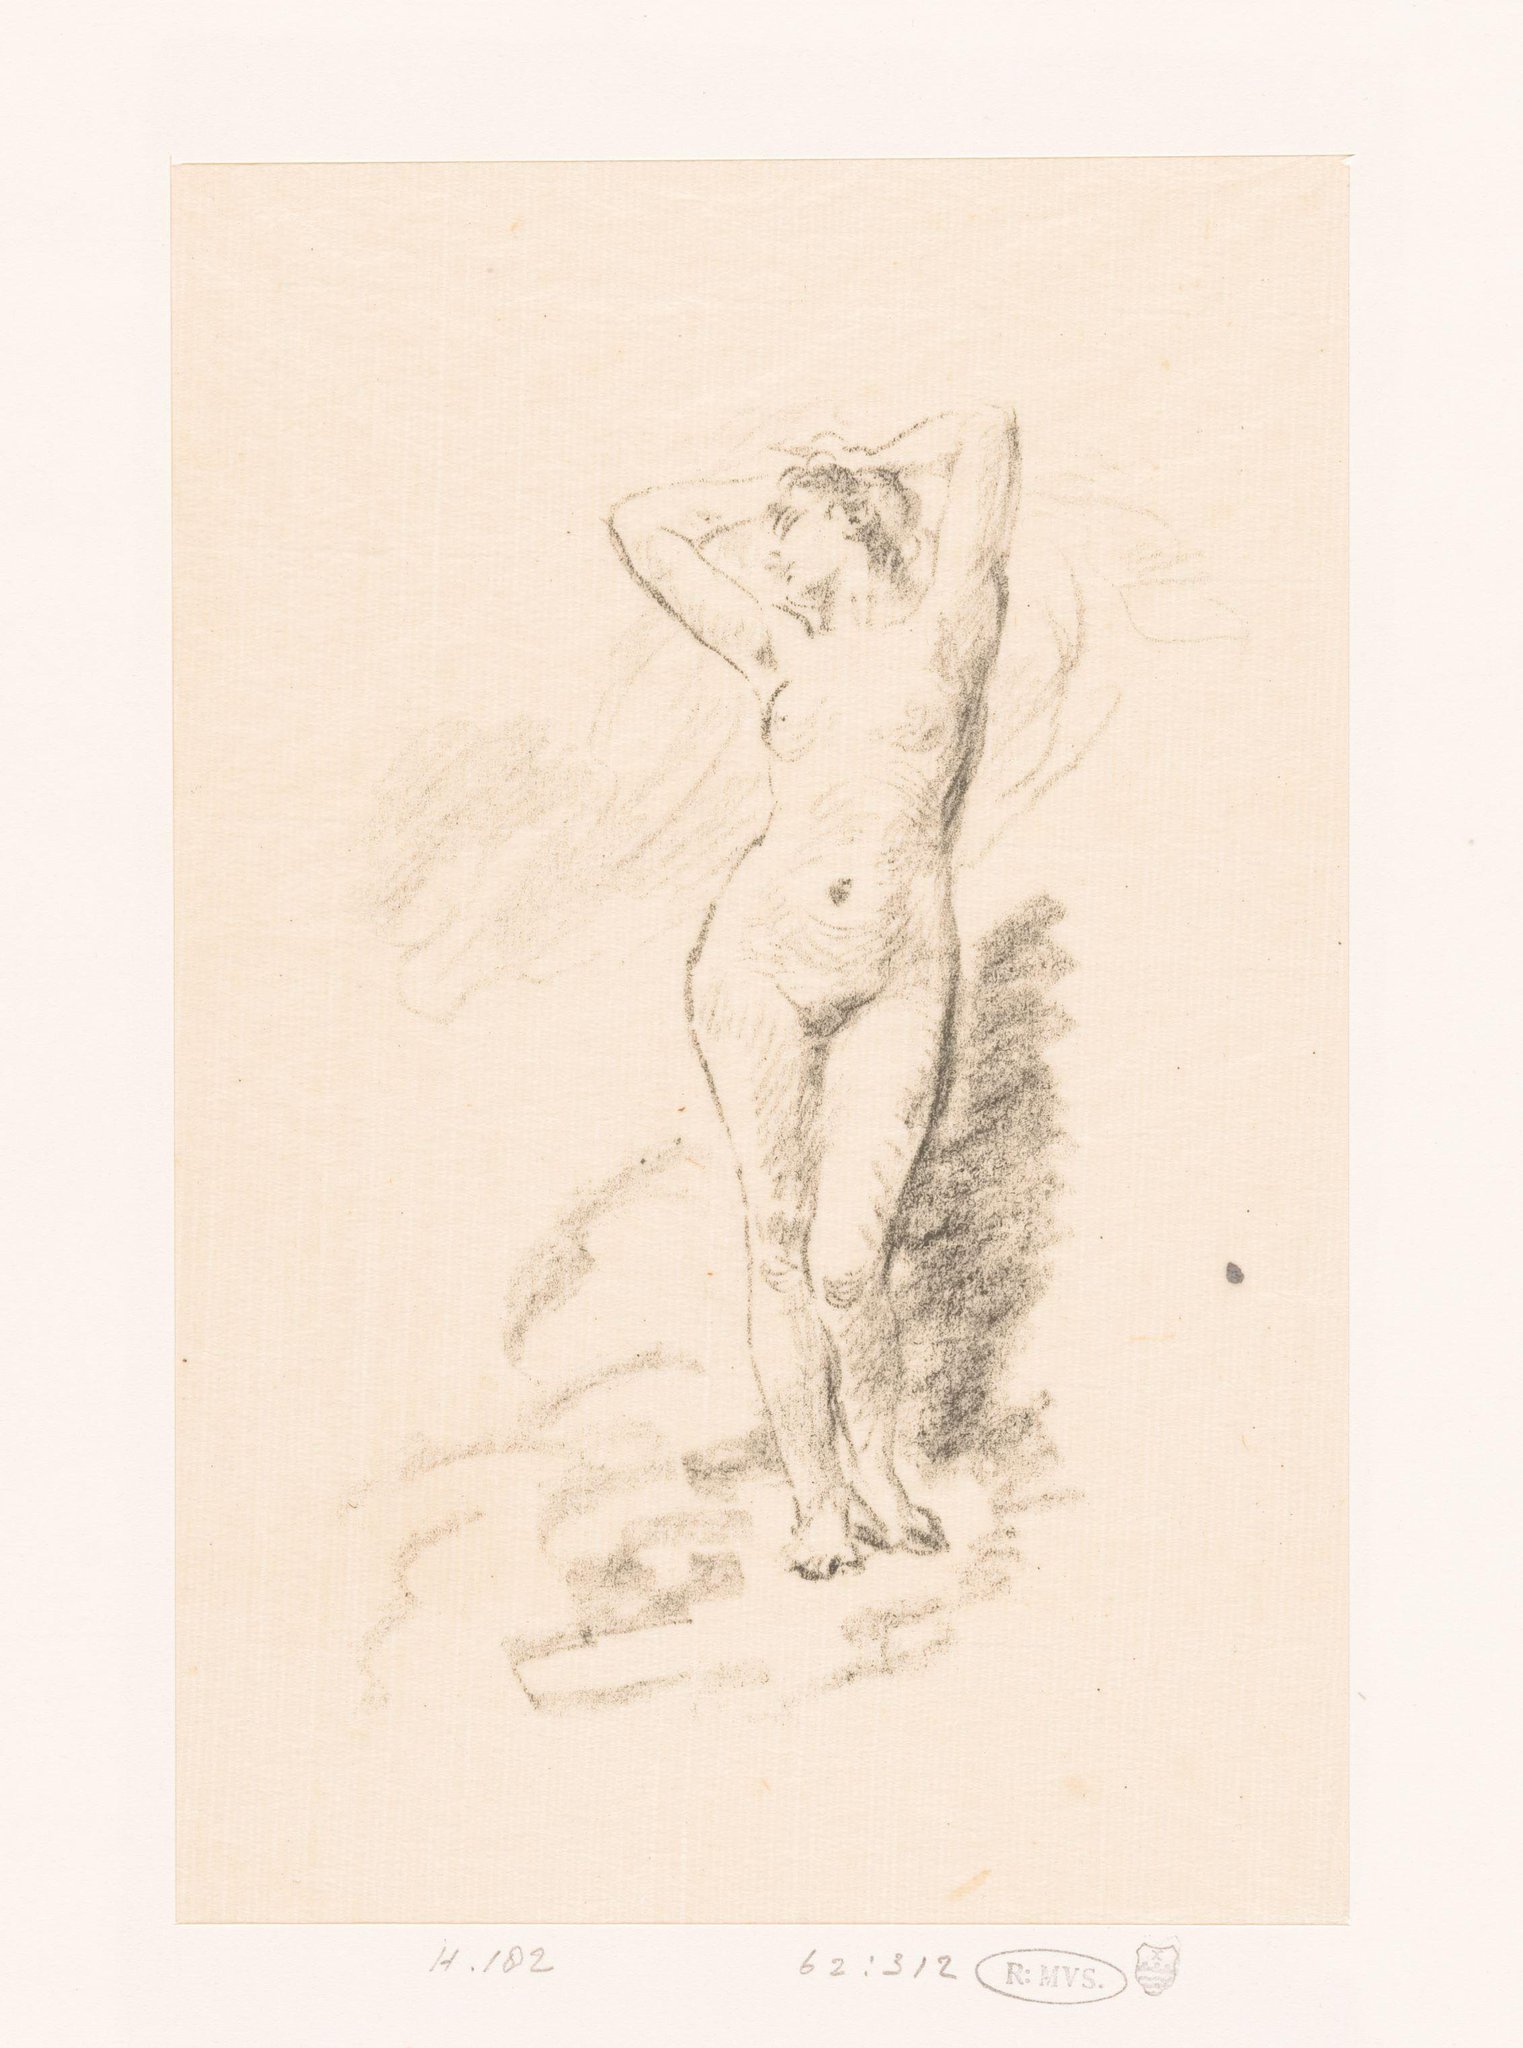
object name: print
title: Studie van een staande naakte vrouw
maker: henri fantin-latour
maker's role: draughtsman, print maker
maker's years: 1836-1904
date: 1903-1904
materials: paper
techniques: lithography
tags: woman (showing herself) undressed, quasi-nude, the (nude) human figure; 'corpo humano' (ripa) - aa - female human figure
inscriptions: collector's mark: Lugt 2760, collector's mark: Lugt 2228a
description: Het blad is een fragment van de hele prent.